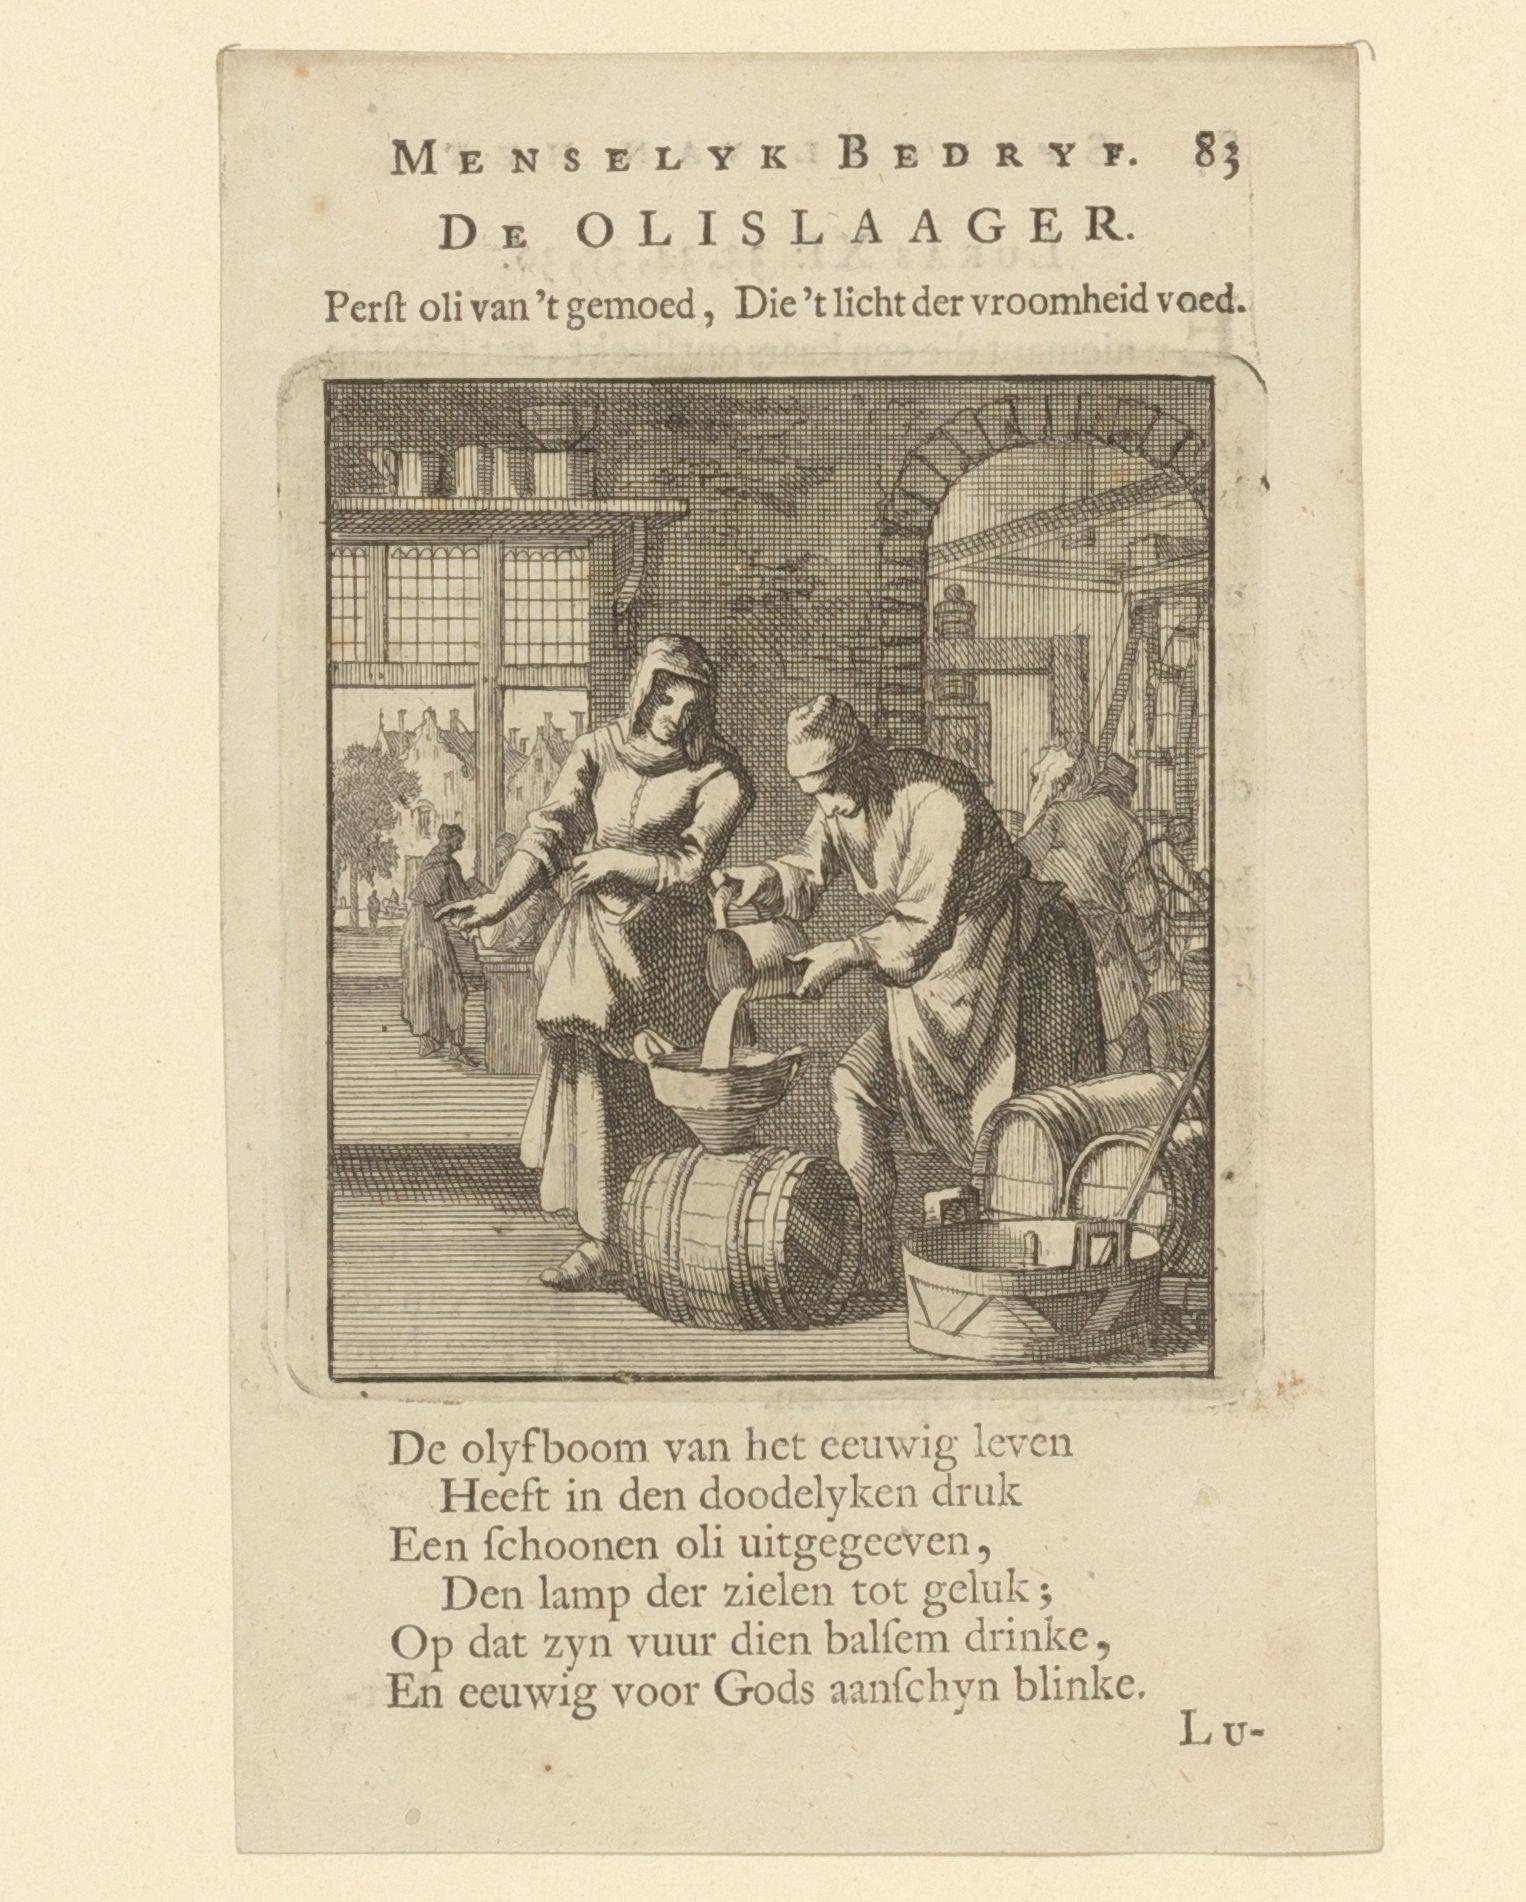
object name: print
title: De Olislaager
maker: jan luyken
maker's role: draughtsman, print maker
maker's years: 1649-1712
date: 1694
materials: paper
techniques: engraving, etching, letterpress printing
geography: netherlands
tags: pressing (industrial process) (+ oil ~ crafts, industries, agriculture), handicrafts, craftsman at work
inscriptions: collector's mark: Lugt 1641, collector's mark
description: Olieslager schenkt olie door een trechter in een ton. Onderaan een zesregelig vers. Bedrukt met tekst op verso. Onderwerpsrubrieken binnen de Atlas Zeden en Gewoonten: Mannelijk beroep en bedrijf: Lantaarnmaker, olieslager, kaarsenmaker.